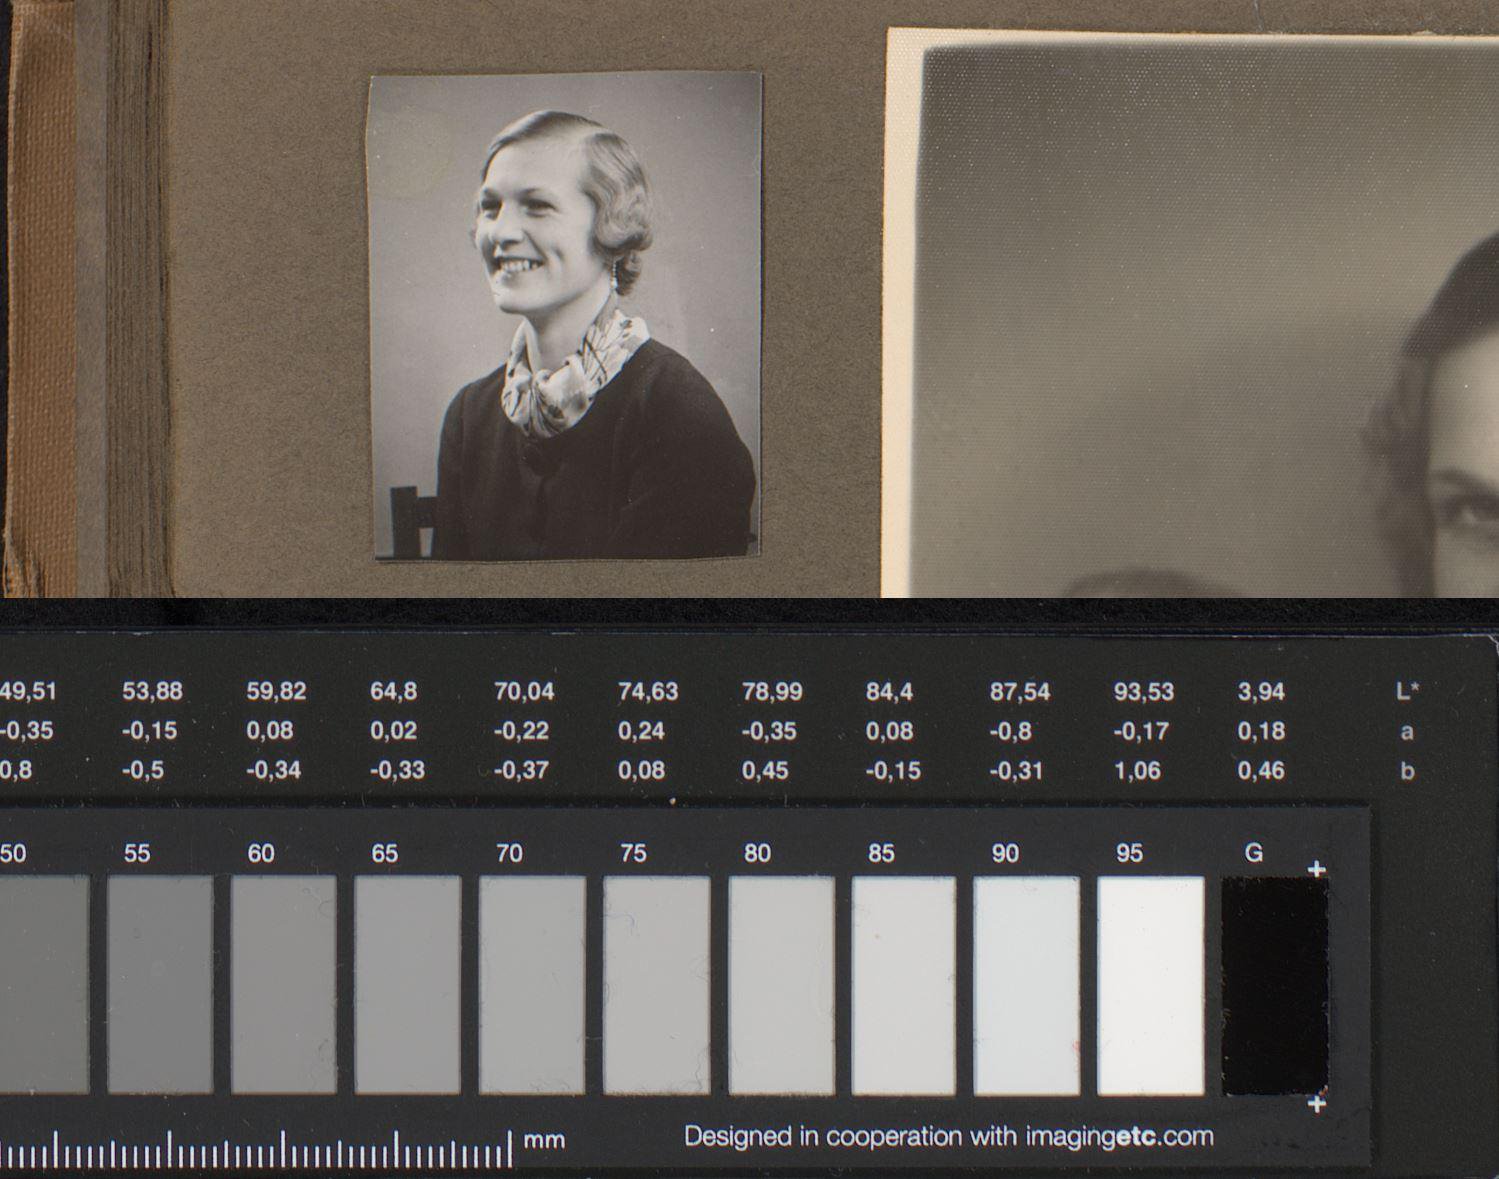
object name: photograph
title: Portret van Corry Mak van Waay-Zulver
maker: Anonymous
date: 1934-1935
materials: paper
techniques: gelatin silver print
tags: historical persons - bb - woman